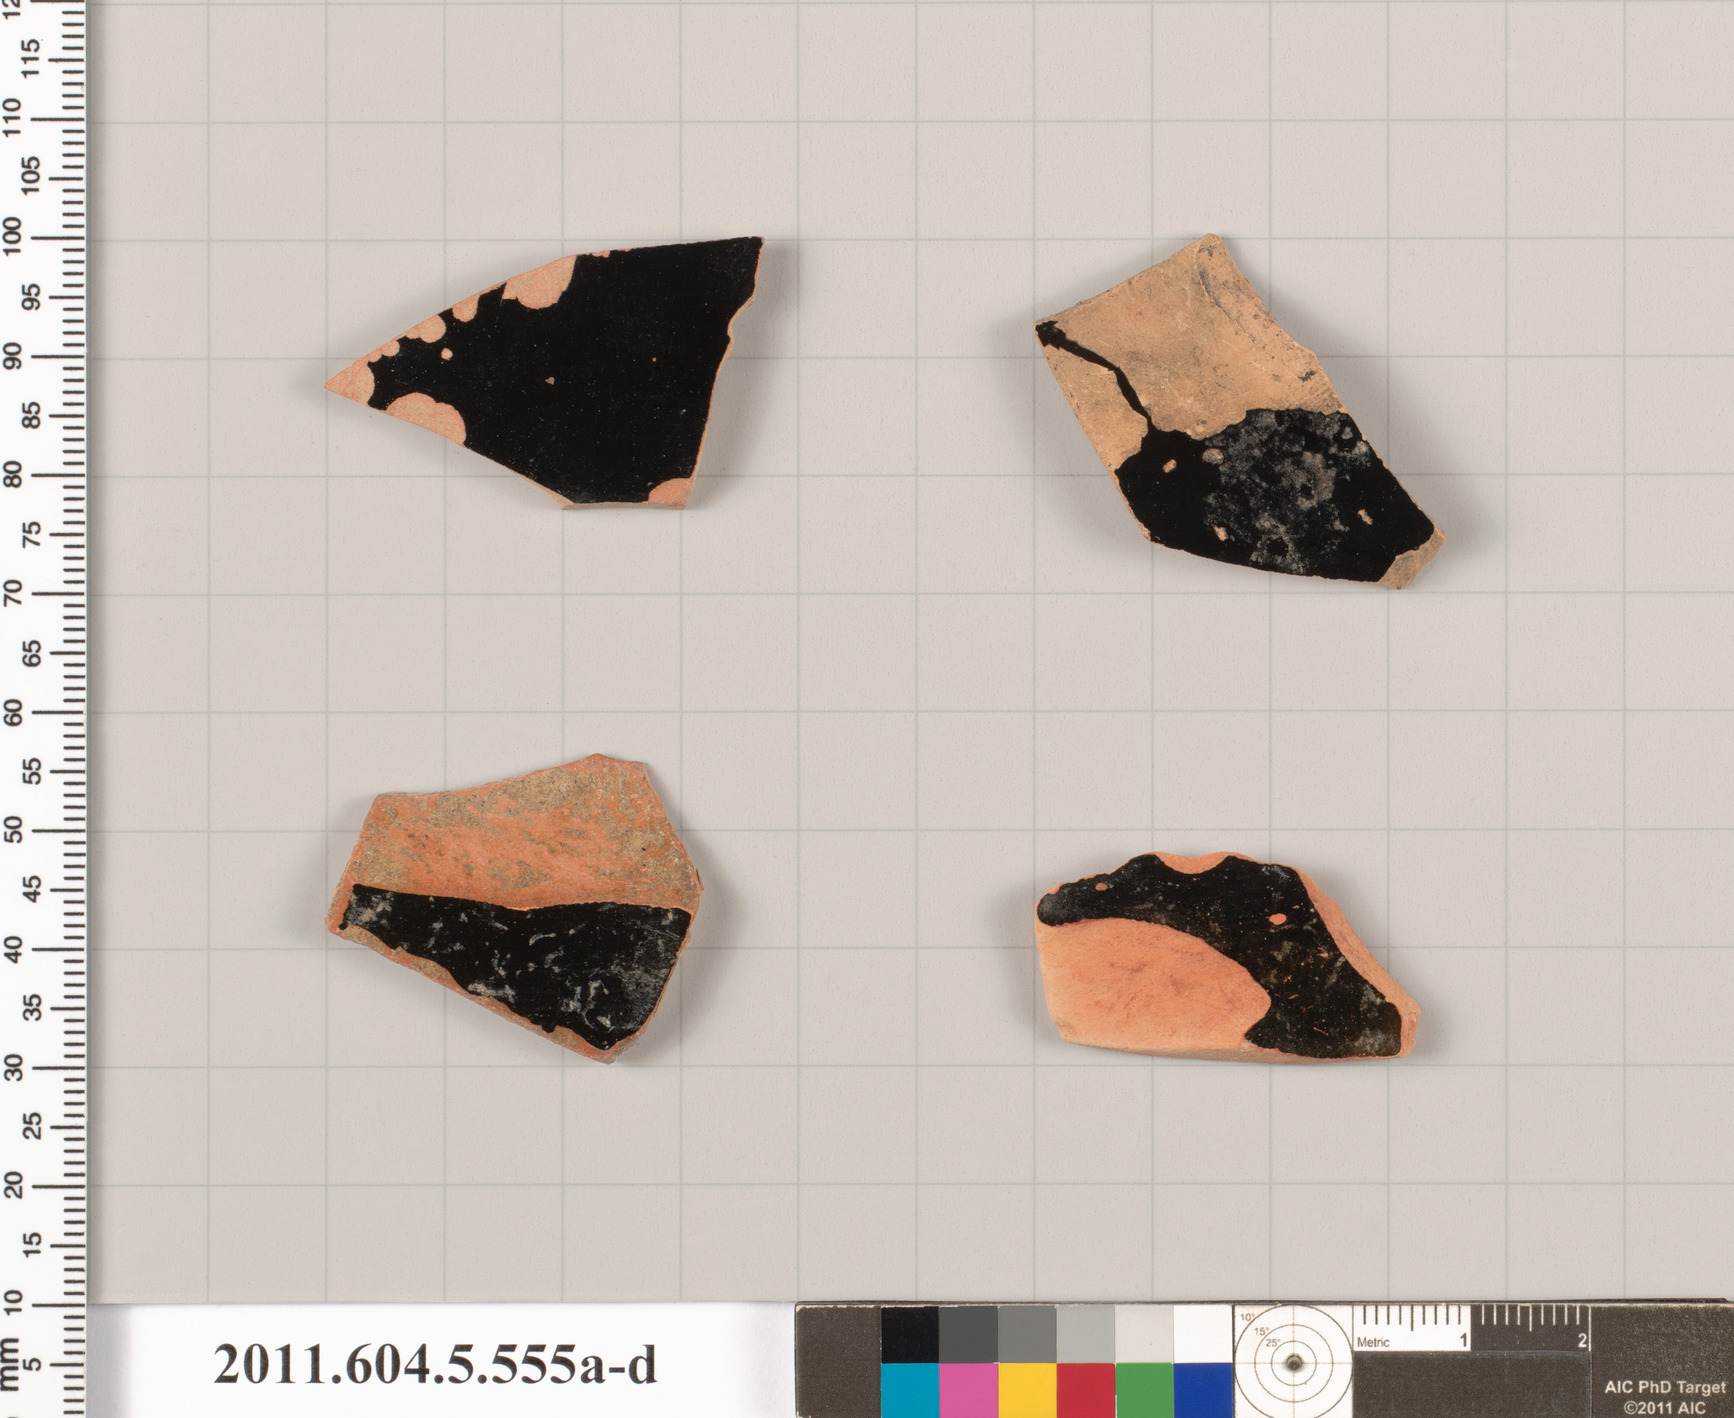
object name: kylix fragment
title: Terracotta fragments of kylikes (drinking cups)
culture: greek, attic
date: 600-401 BCE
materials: terracotta